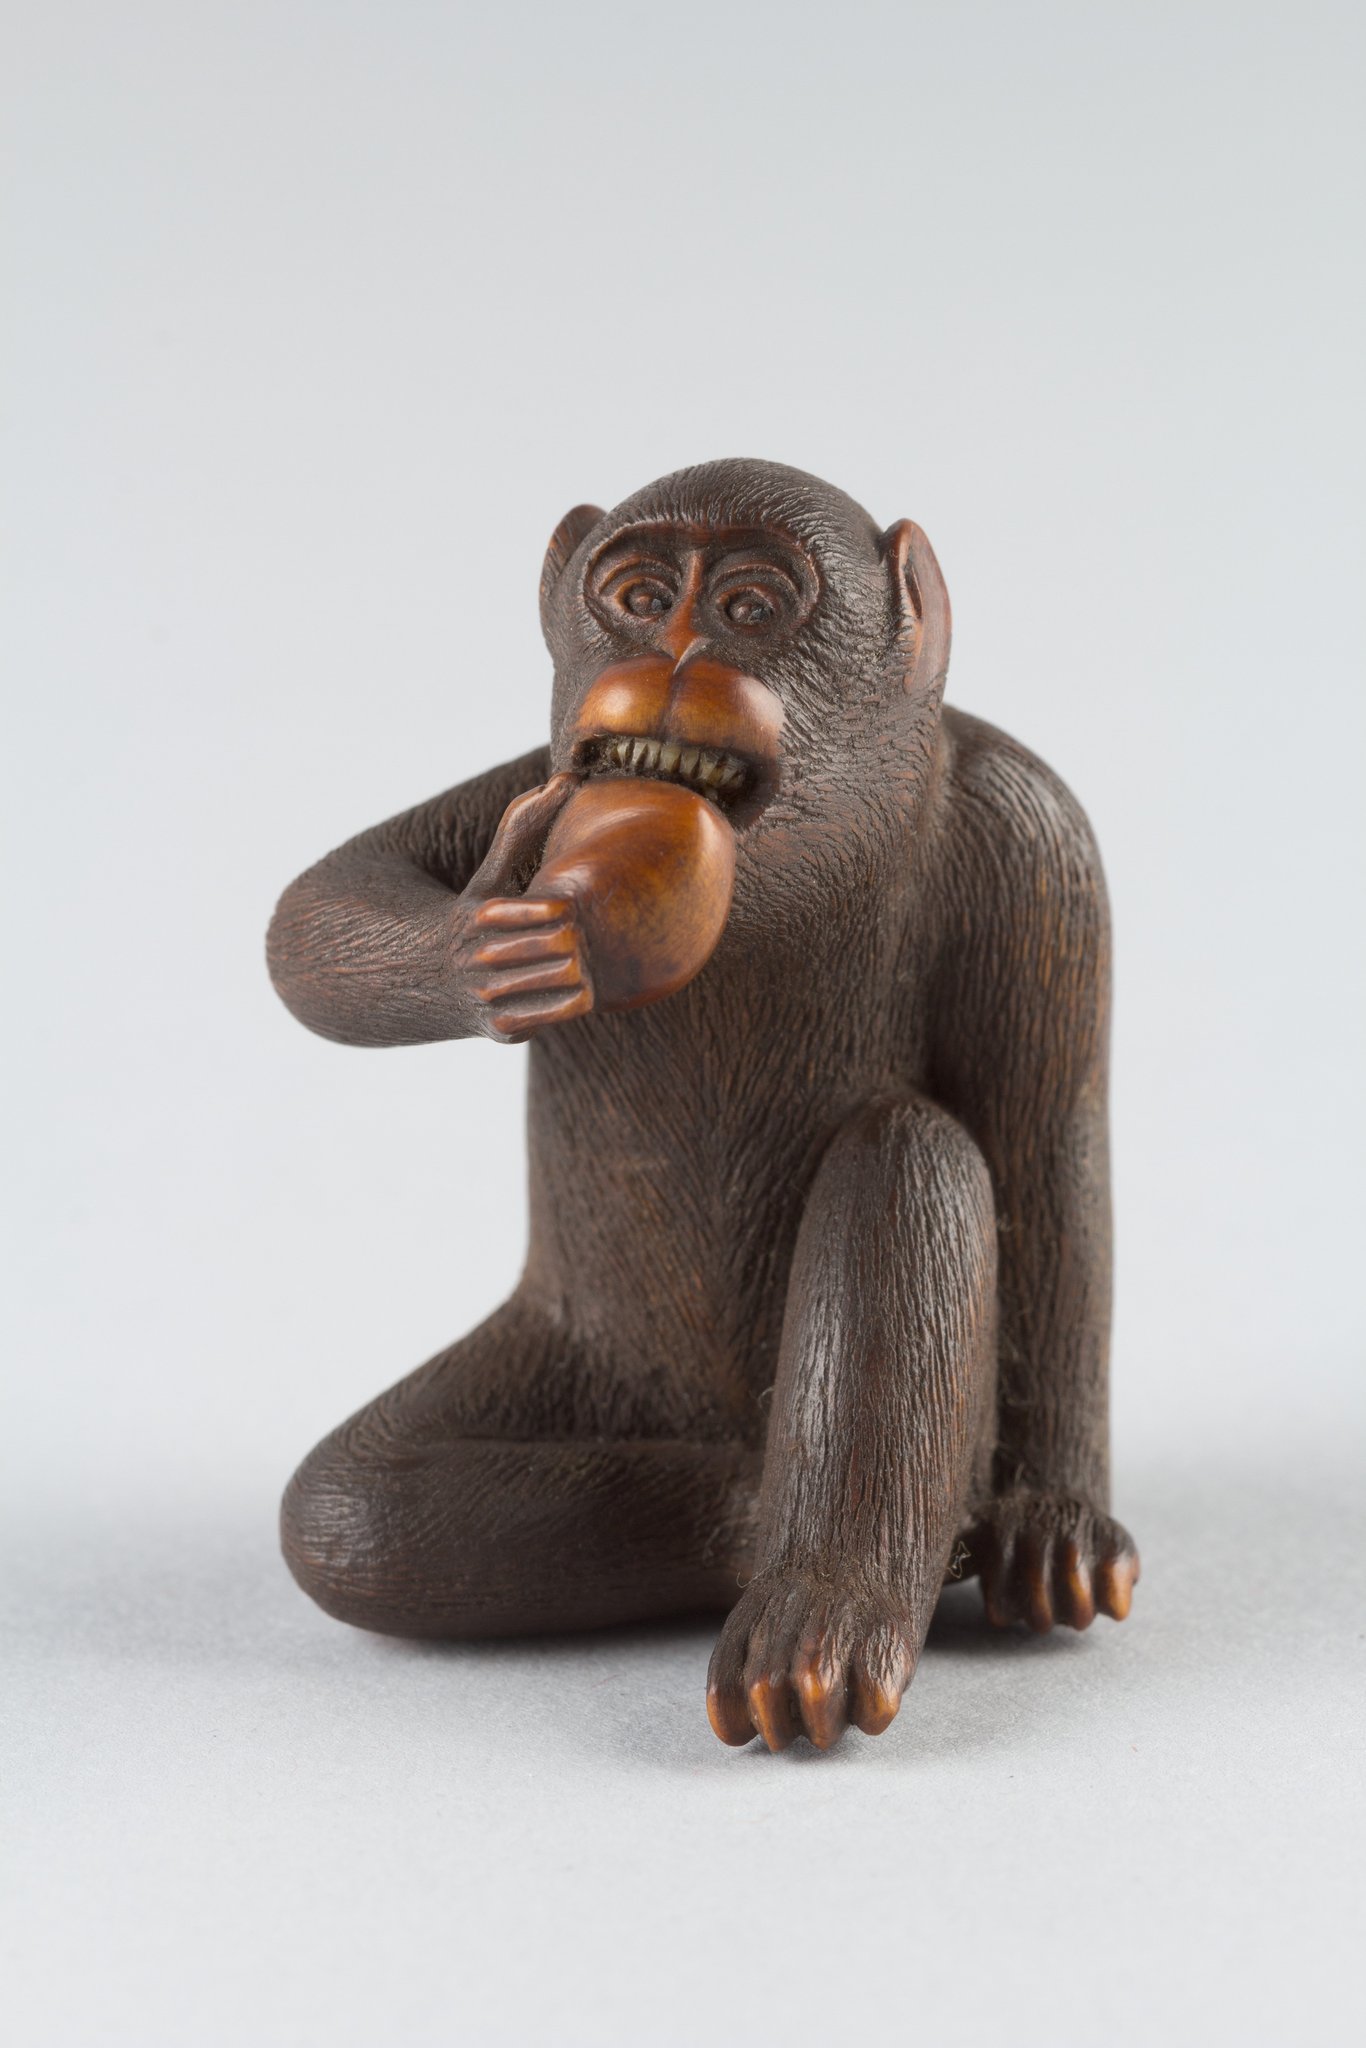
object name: netsuke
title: Netsuke of Monkey Eating a Peach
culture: japanese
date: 1801-1900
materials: wood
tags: peaches,monkeys